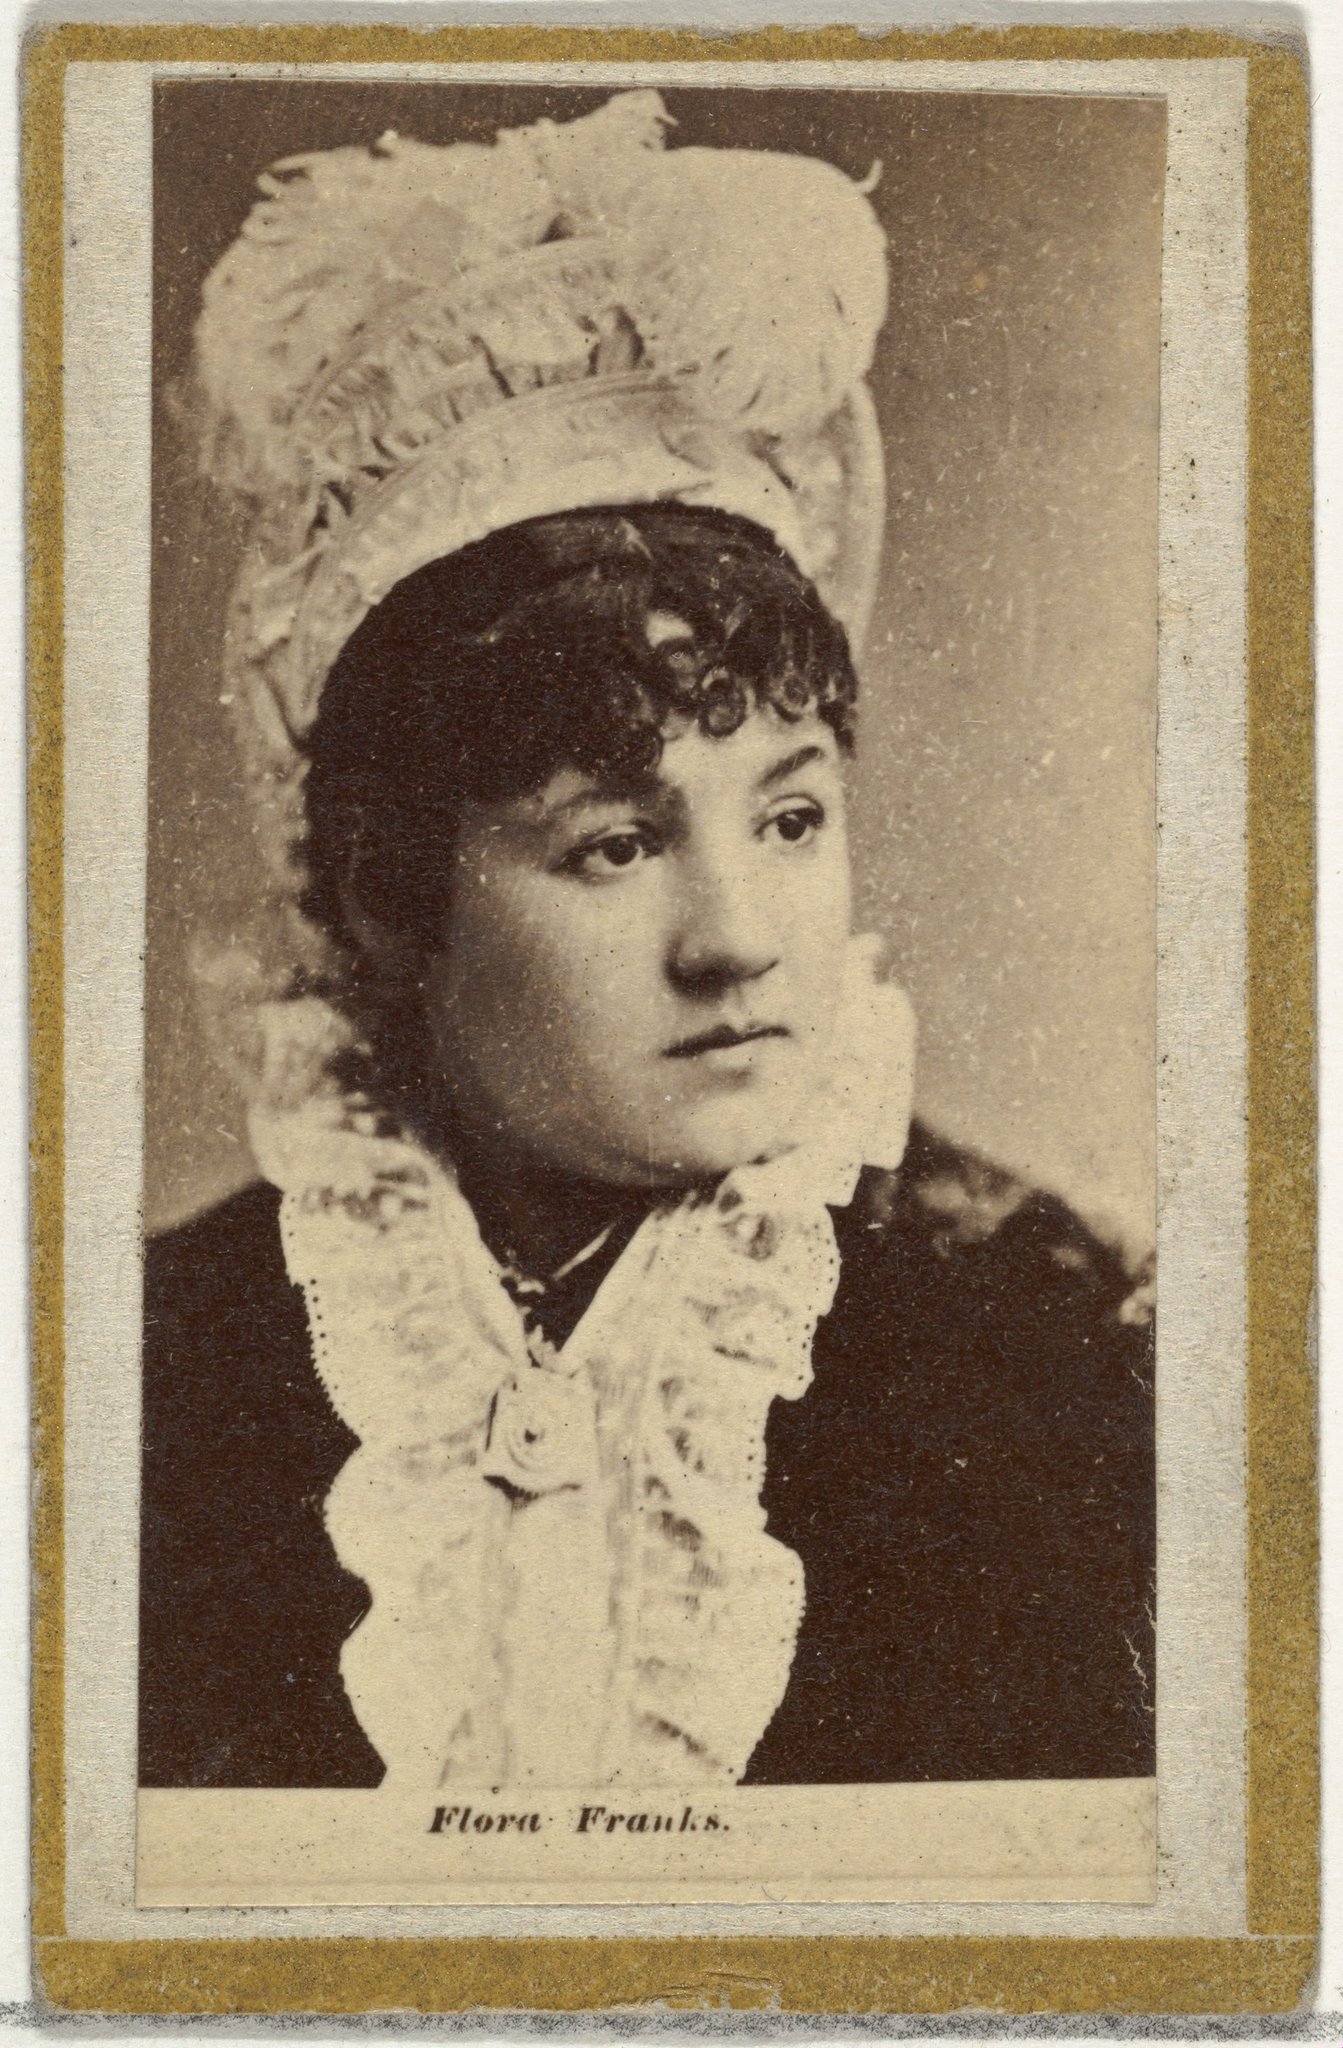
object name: photograph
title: Flora Franks, from the Actresses and Celebrities series (N60, Type 2) promoting Little Beauties Cigarettes for Allen & Ginter brand tobacco products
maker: allen & ginter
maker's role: publisher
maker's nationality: american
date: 1887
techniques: albumen silver print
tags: portraits,women,actresses